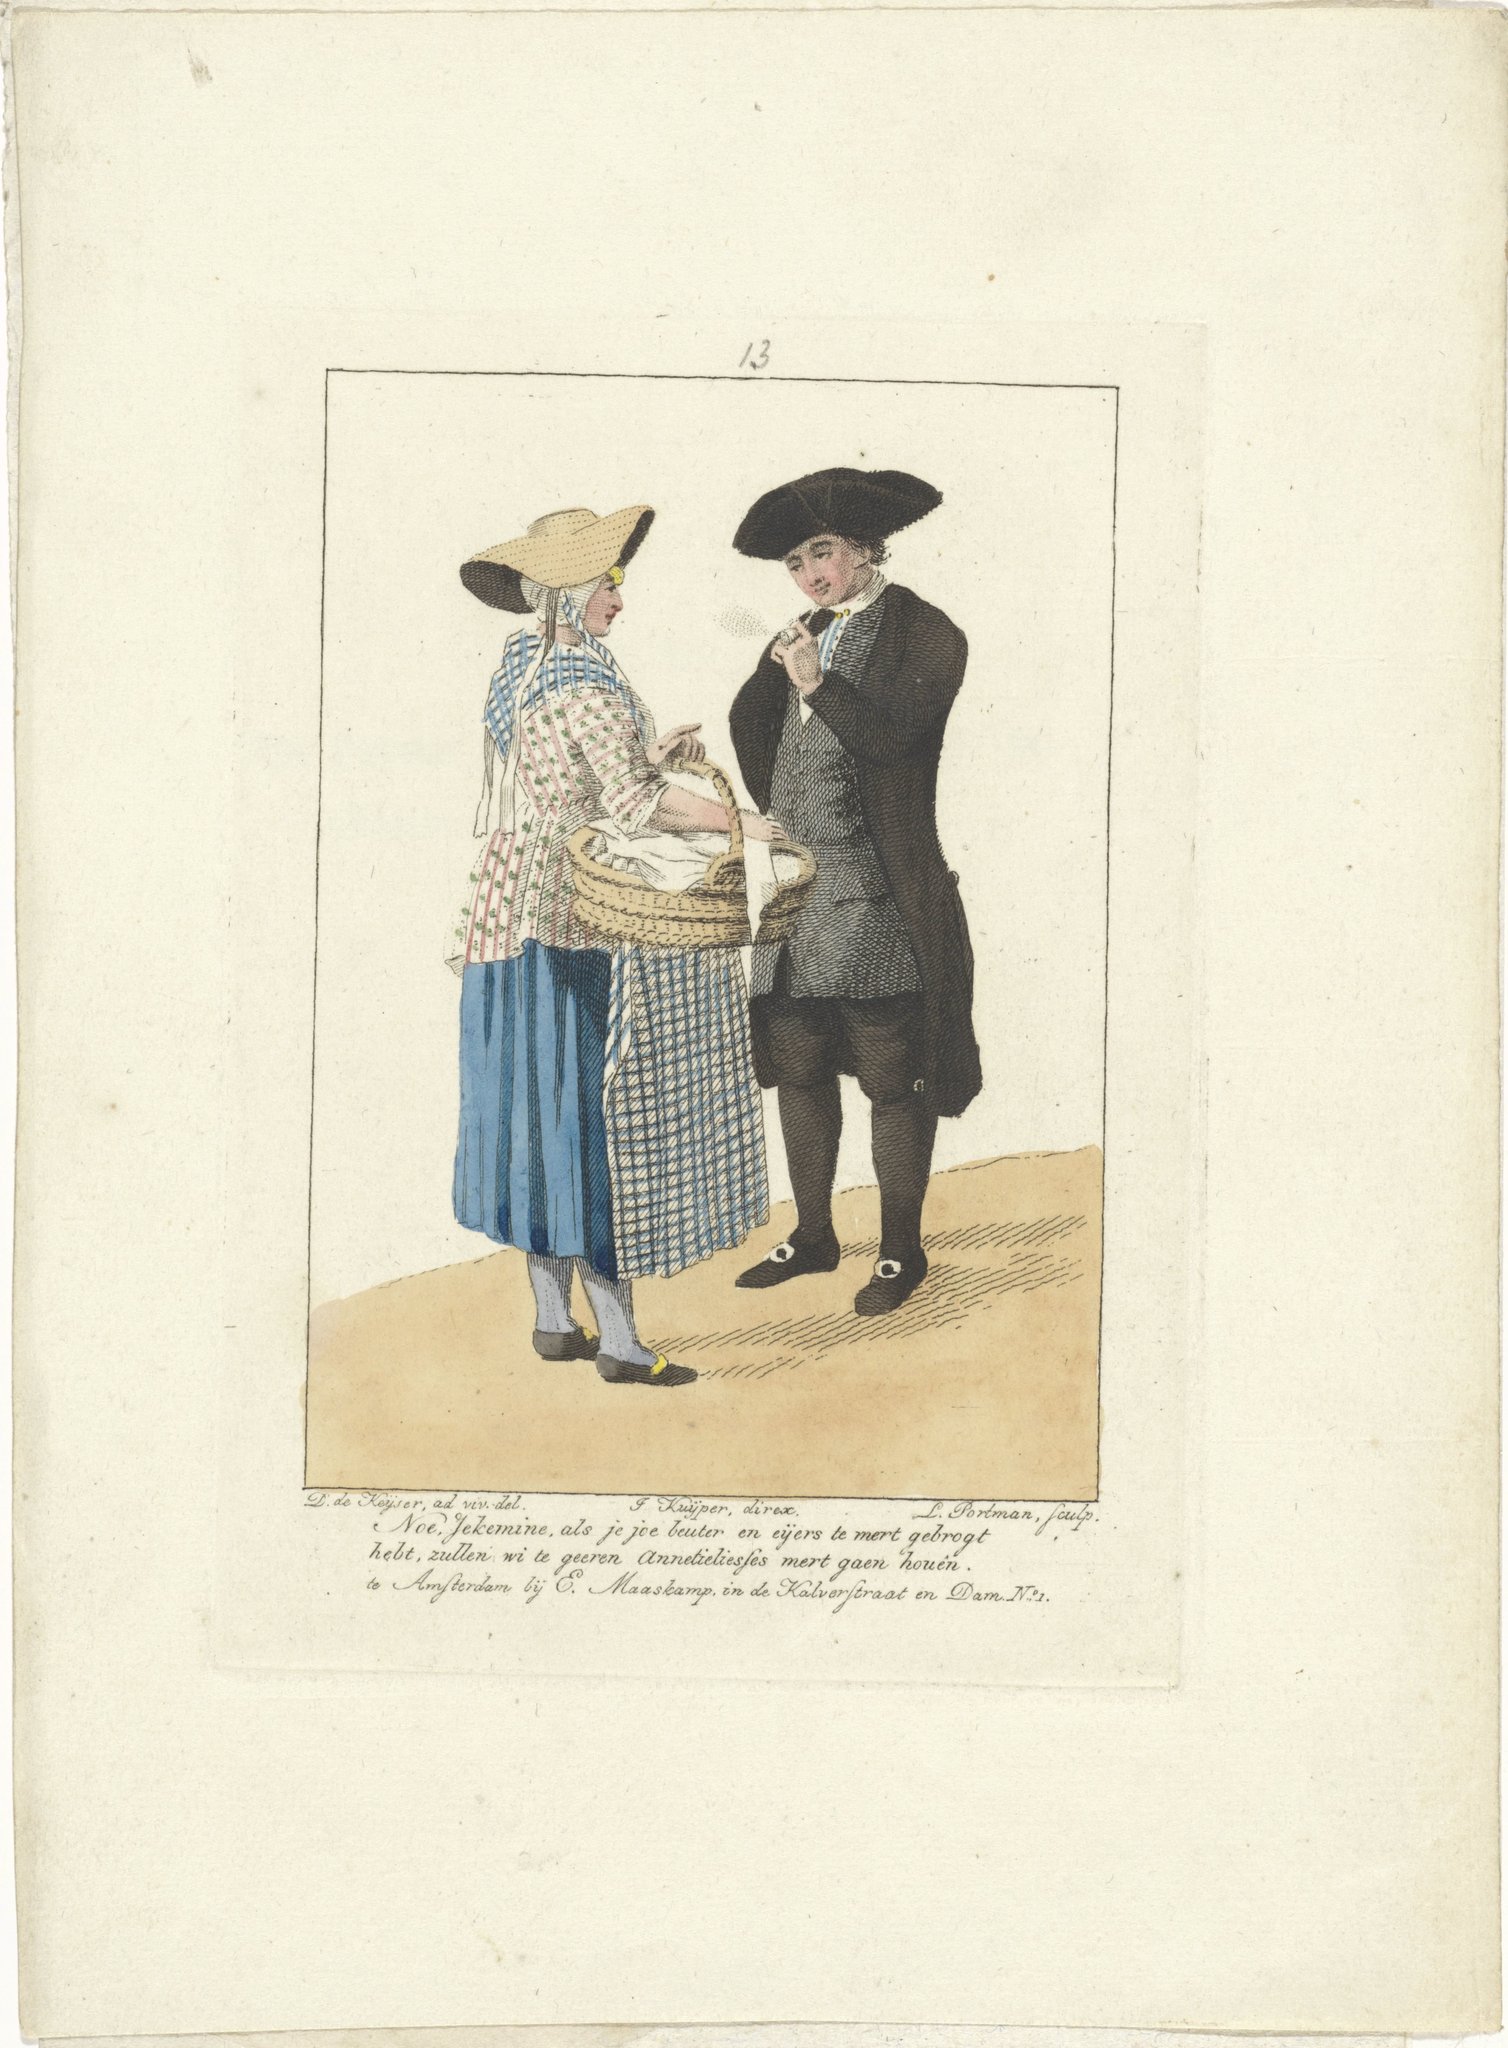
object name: print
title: Noe, Jekemine, als je joe beuter en eijers te mert gebrogt hebt, zullen wi te geeren Annetieliesses mert gaen houên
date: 1806-1812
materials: paper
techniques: etching, hand coloring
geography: amsterdam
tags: going to the market, clothes, costume (+ men's clothes), folk costume, regional costume, eggs, egg-dishes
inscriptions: collector's mark: Lugt 2228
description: Illustratie uit: Reis door Holland in het jaar 1806 [en 1807-1812] : met afbeeldingen. Amsterdam: Evert Maaskamp, 1806-1812.